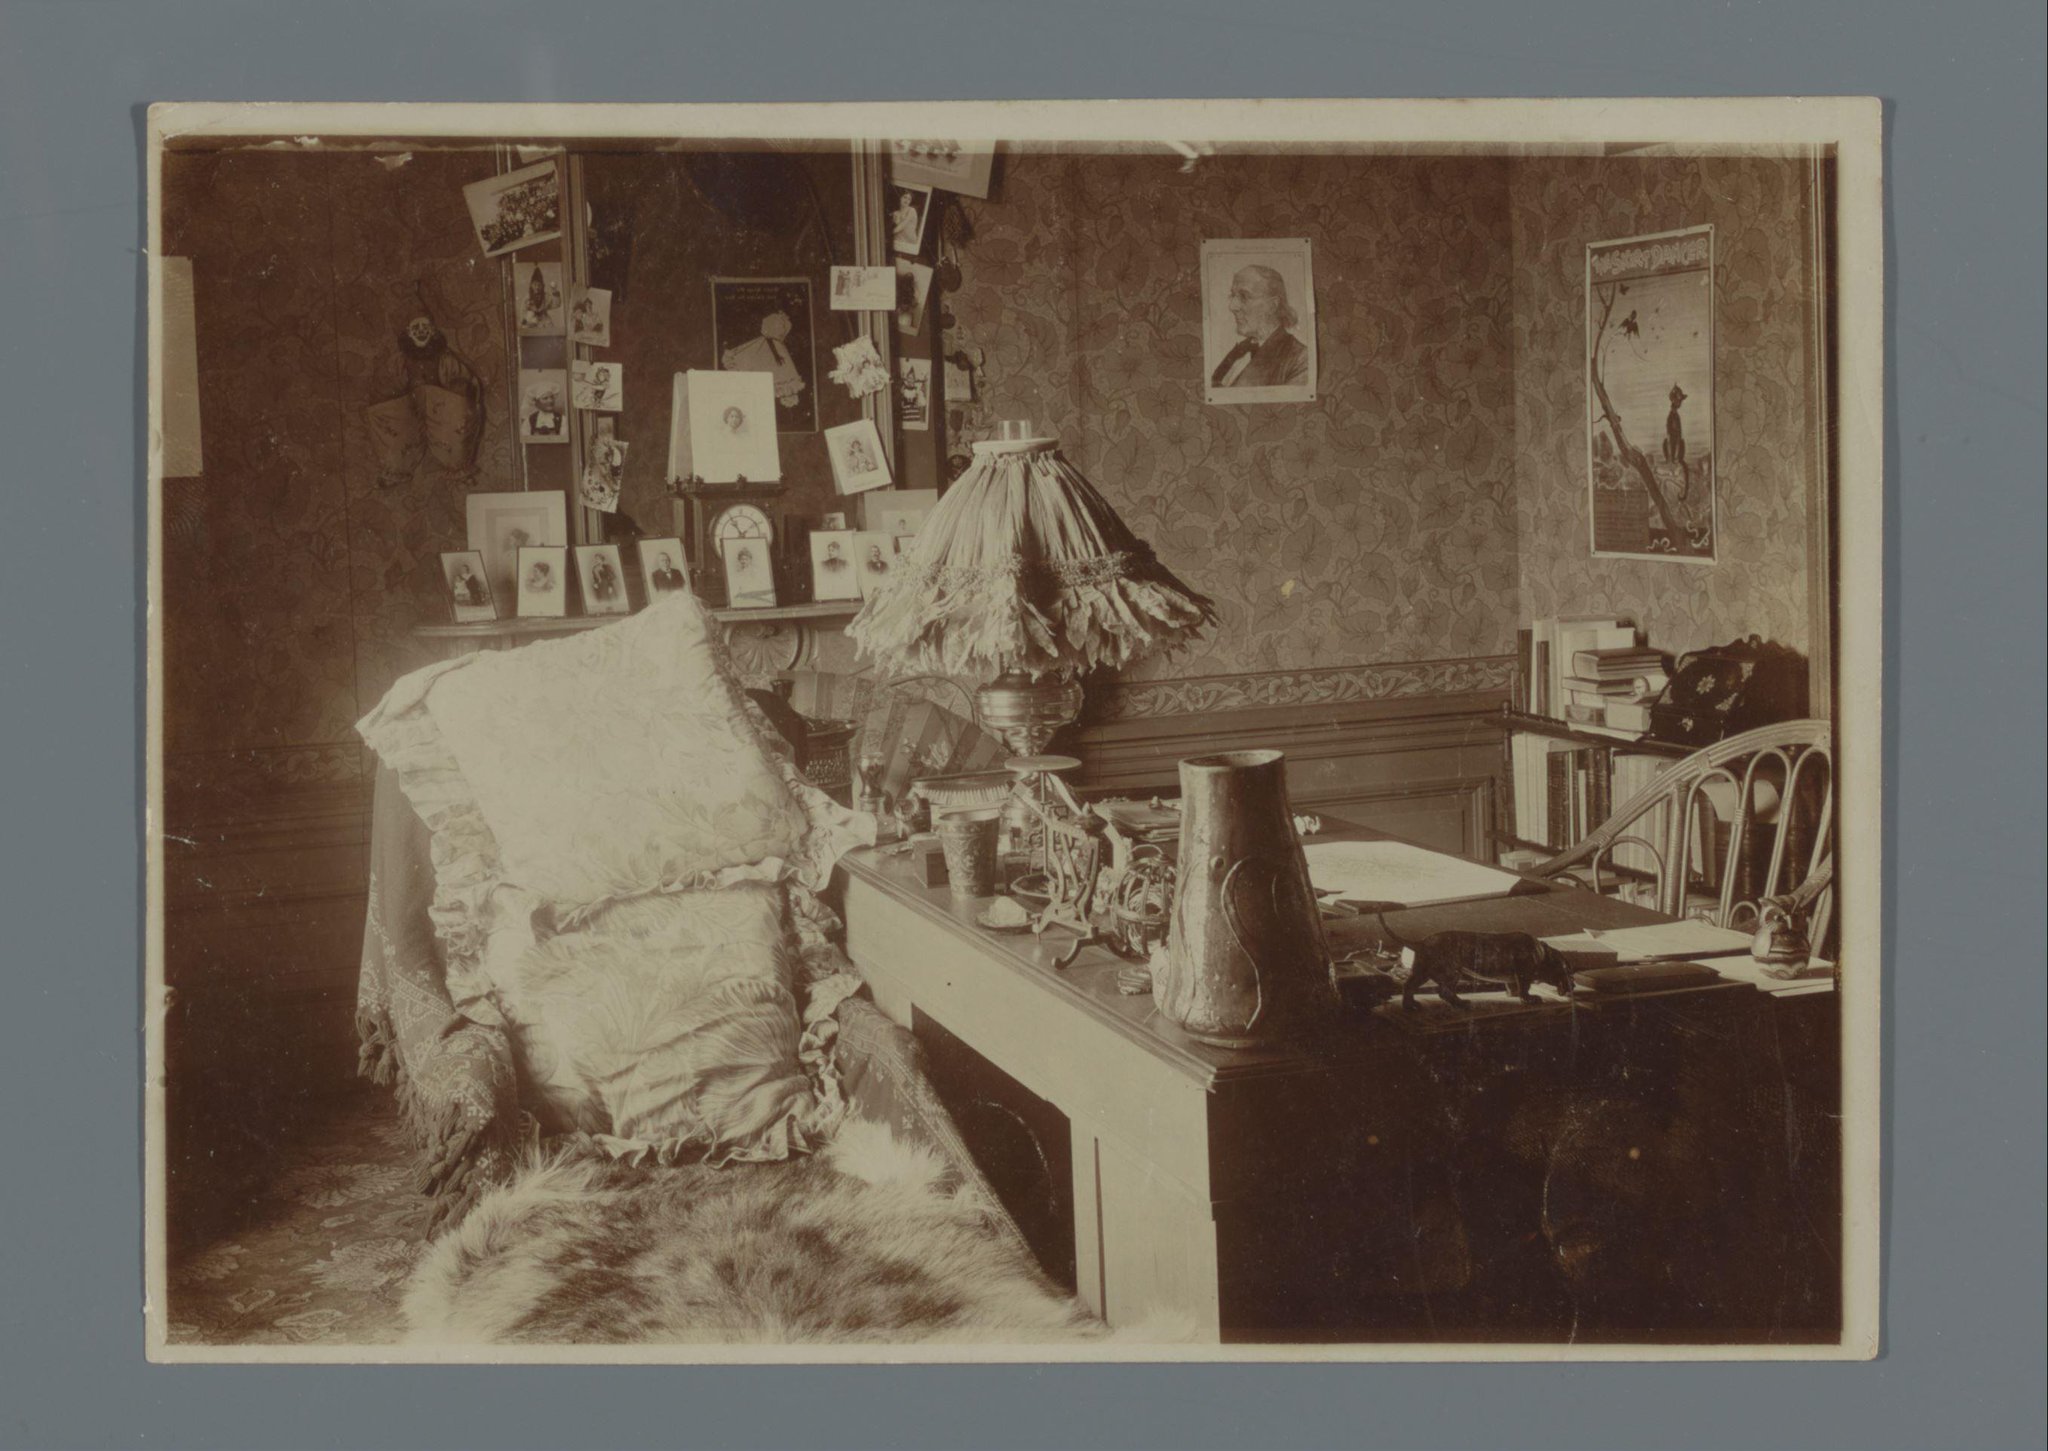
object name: photograph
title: De kamer van Henk van de Berg op de Turfmarkt 3 in Amsterdam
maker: hendrik herman van den berg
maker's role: amateurfotograaf, jurist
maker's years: 1875-1944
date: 1896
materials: photographic support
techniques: collodion silver print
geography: amsterdam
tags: rotterdam, amsterdam, norbertus petrus van den berg (1831-1917), interior of the house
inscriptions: annotation: ‘Vaders kamer oude Turfmarkt 3’